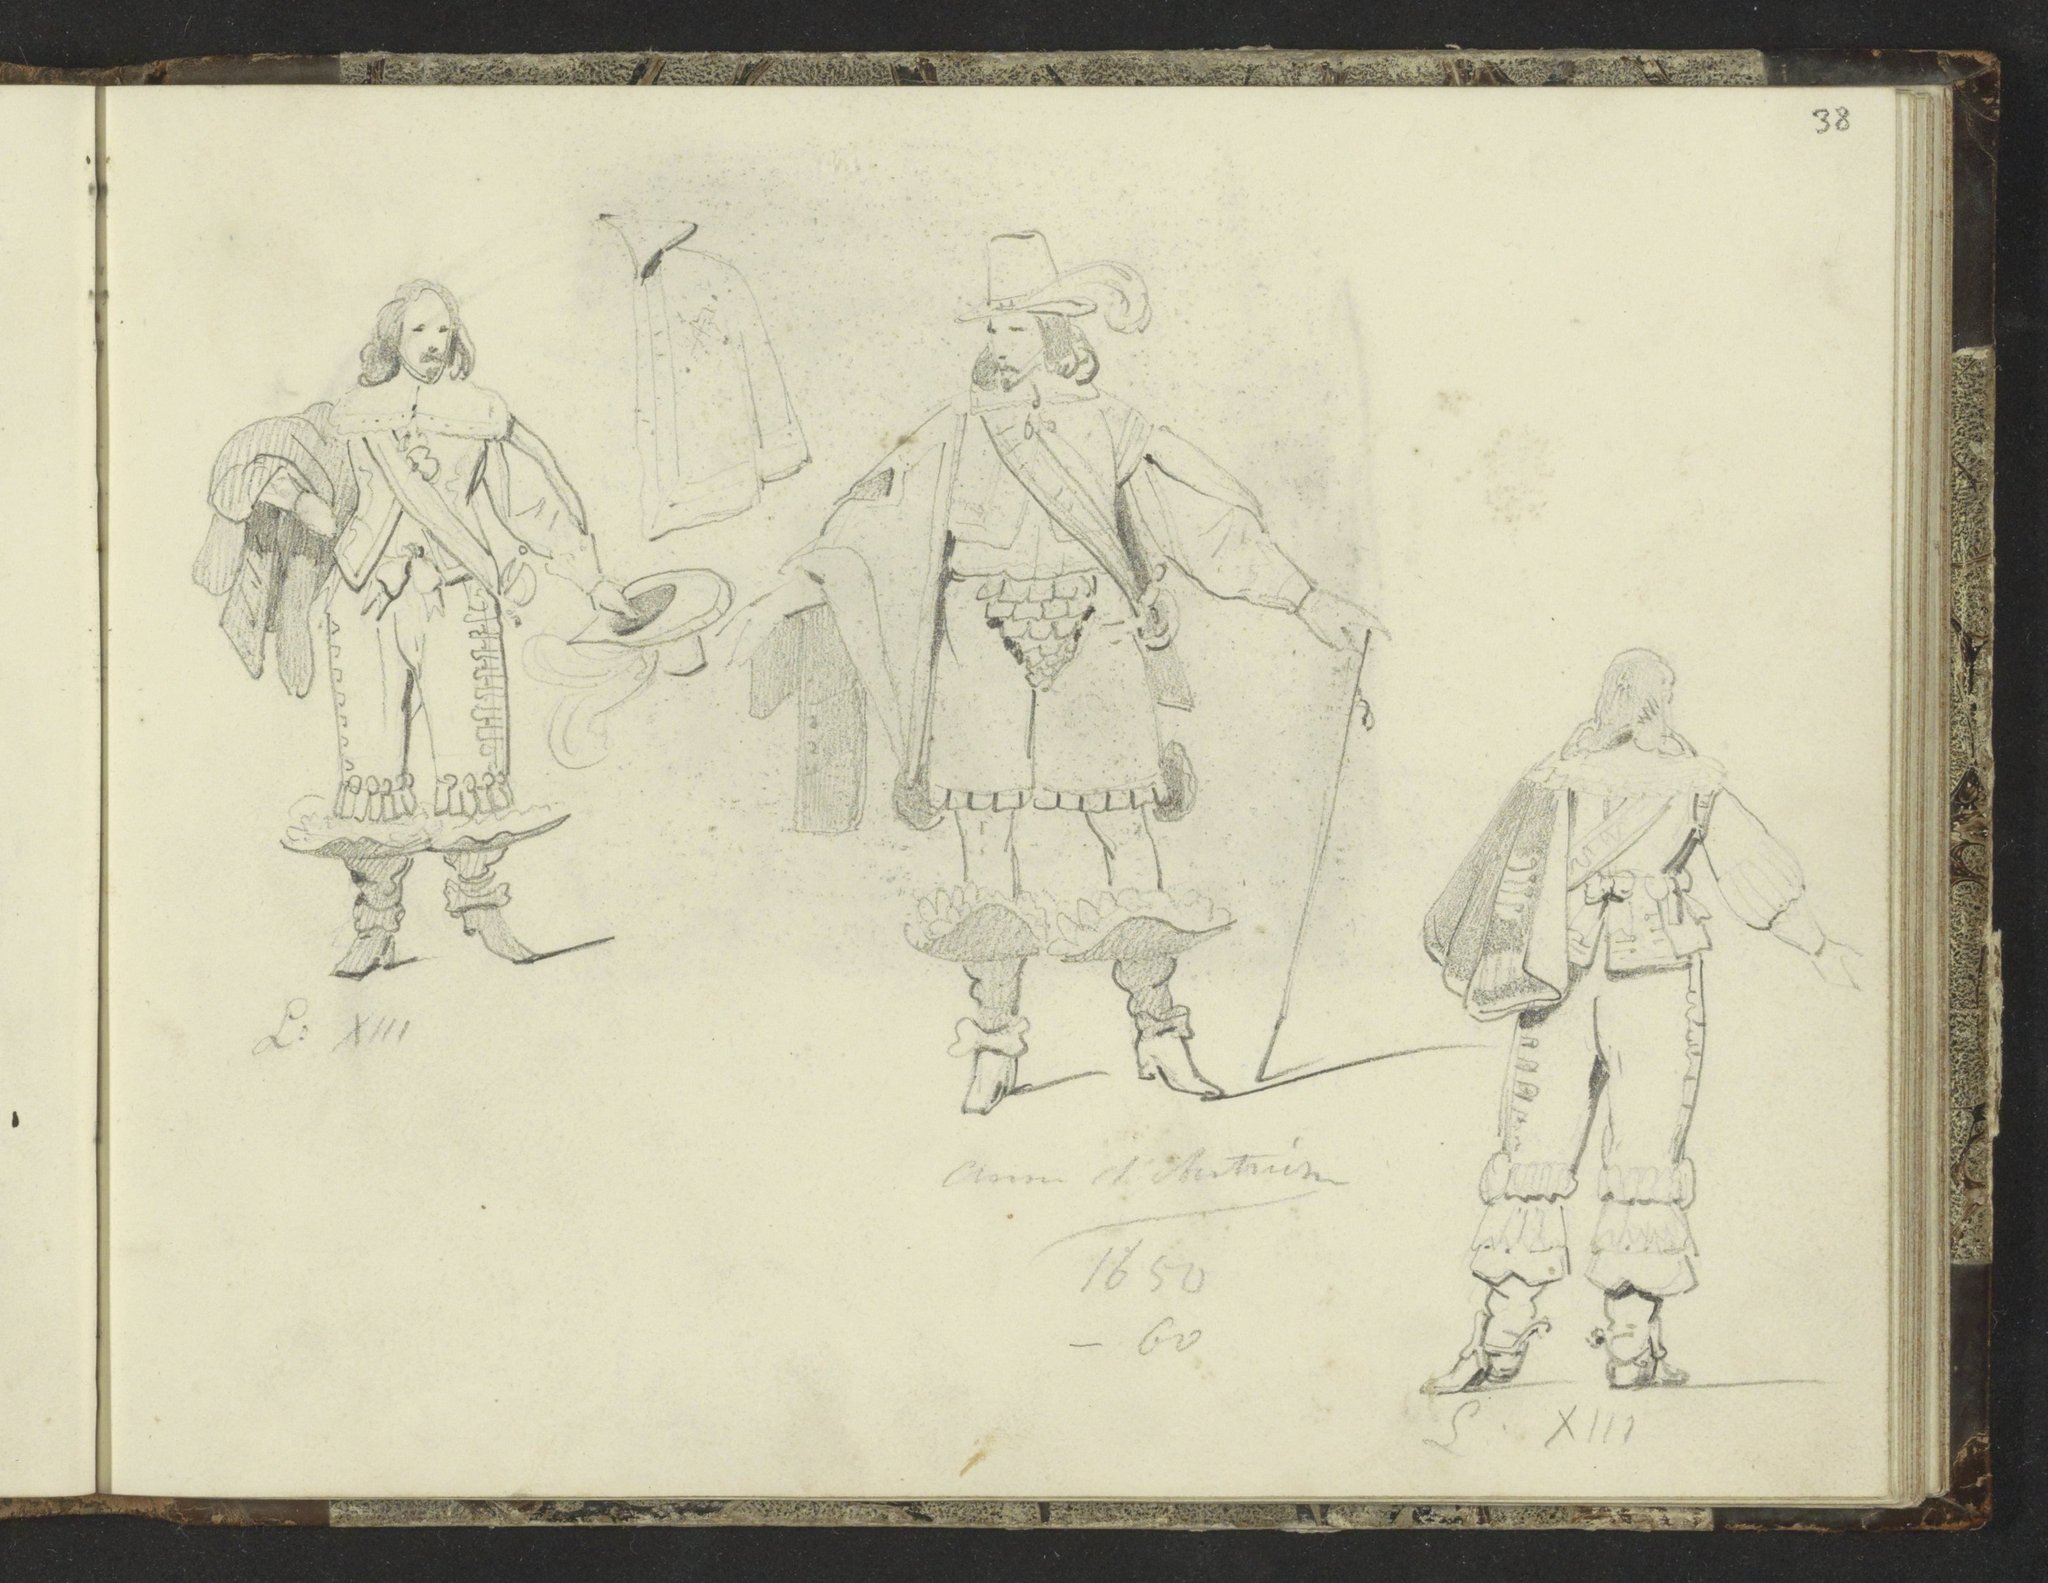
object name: sketchbook leaf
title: Drie mannen in zeventiende-eeuws kostuum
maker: willem hendrik schmidt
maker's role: draughtsman, painter, print maker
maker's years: 1809-1849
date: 1819-1849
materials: paper, pencil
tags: historical costume (+ men's clothes)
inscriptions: annotation: ‘L: XIII/ Anne d'Autriche/ 1650/ -60/ L. XIII’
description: Blad 38 recto uit een schetsboek met 58 bladen.